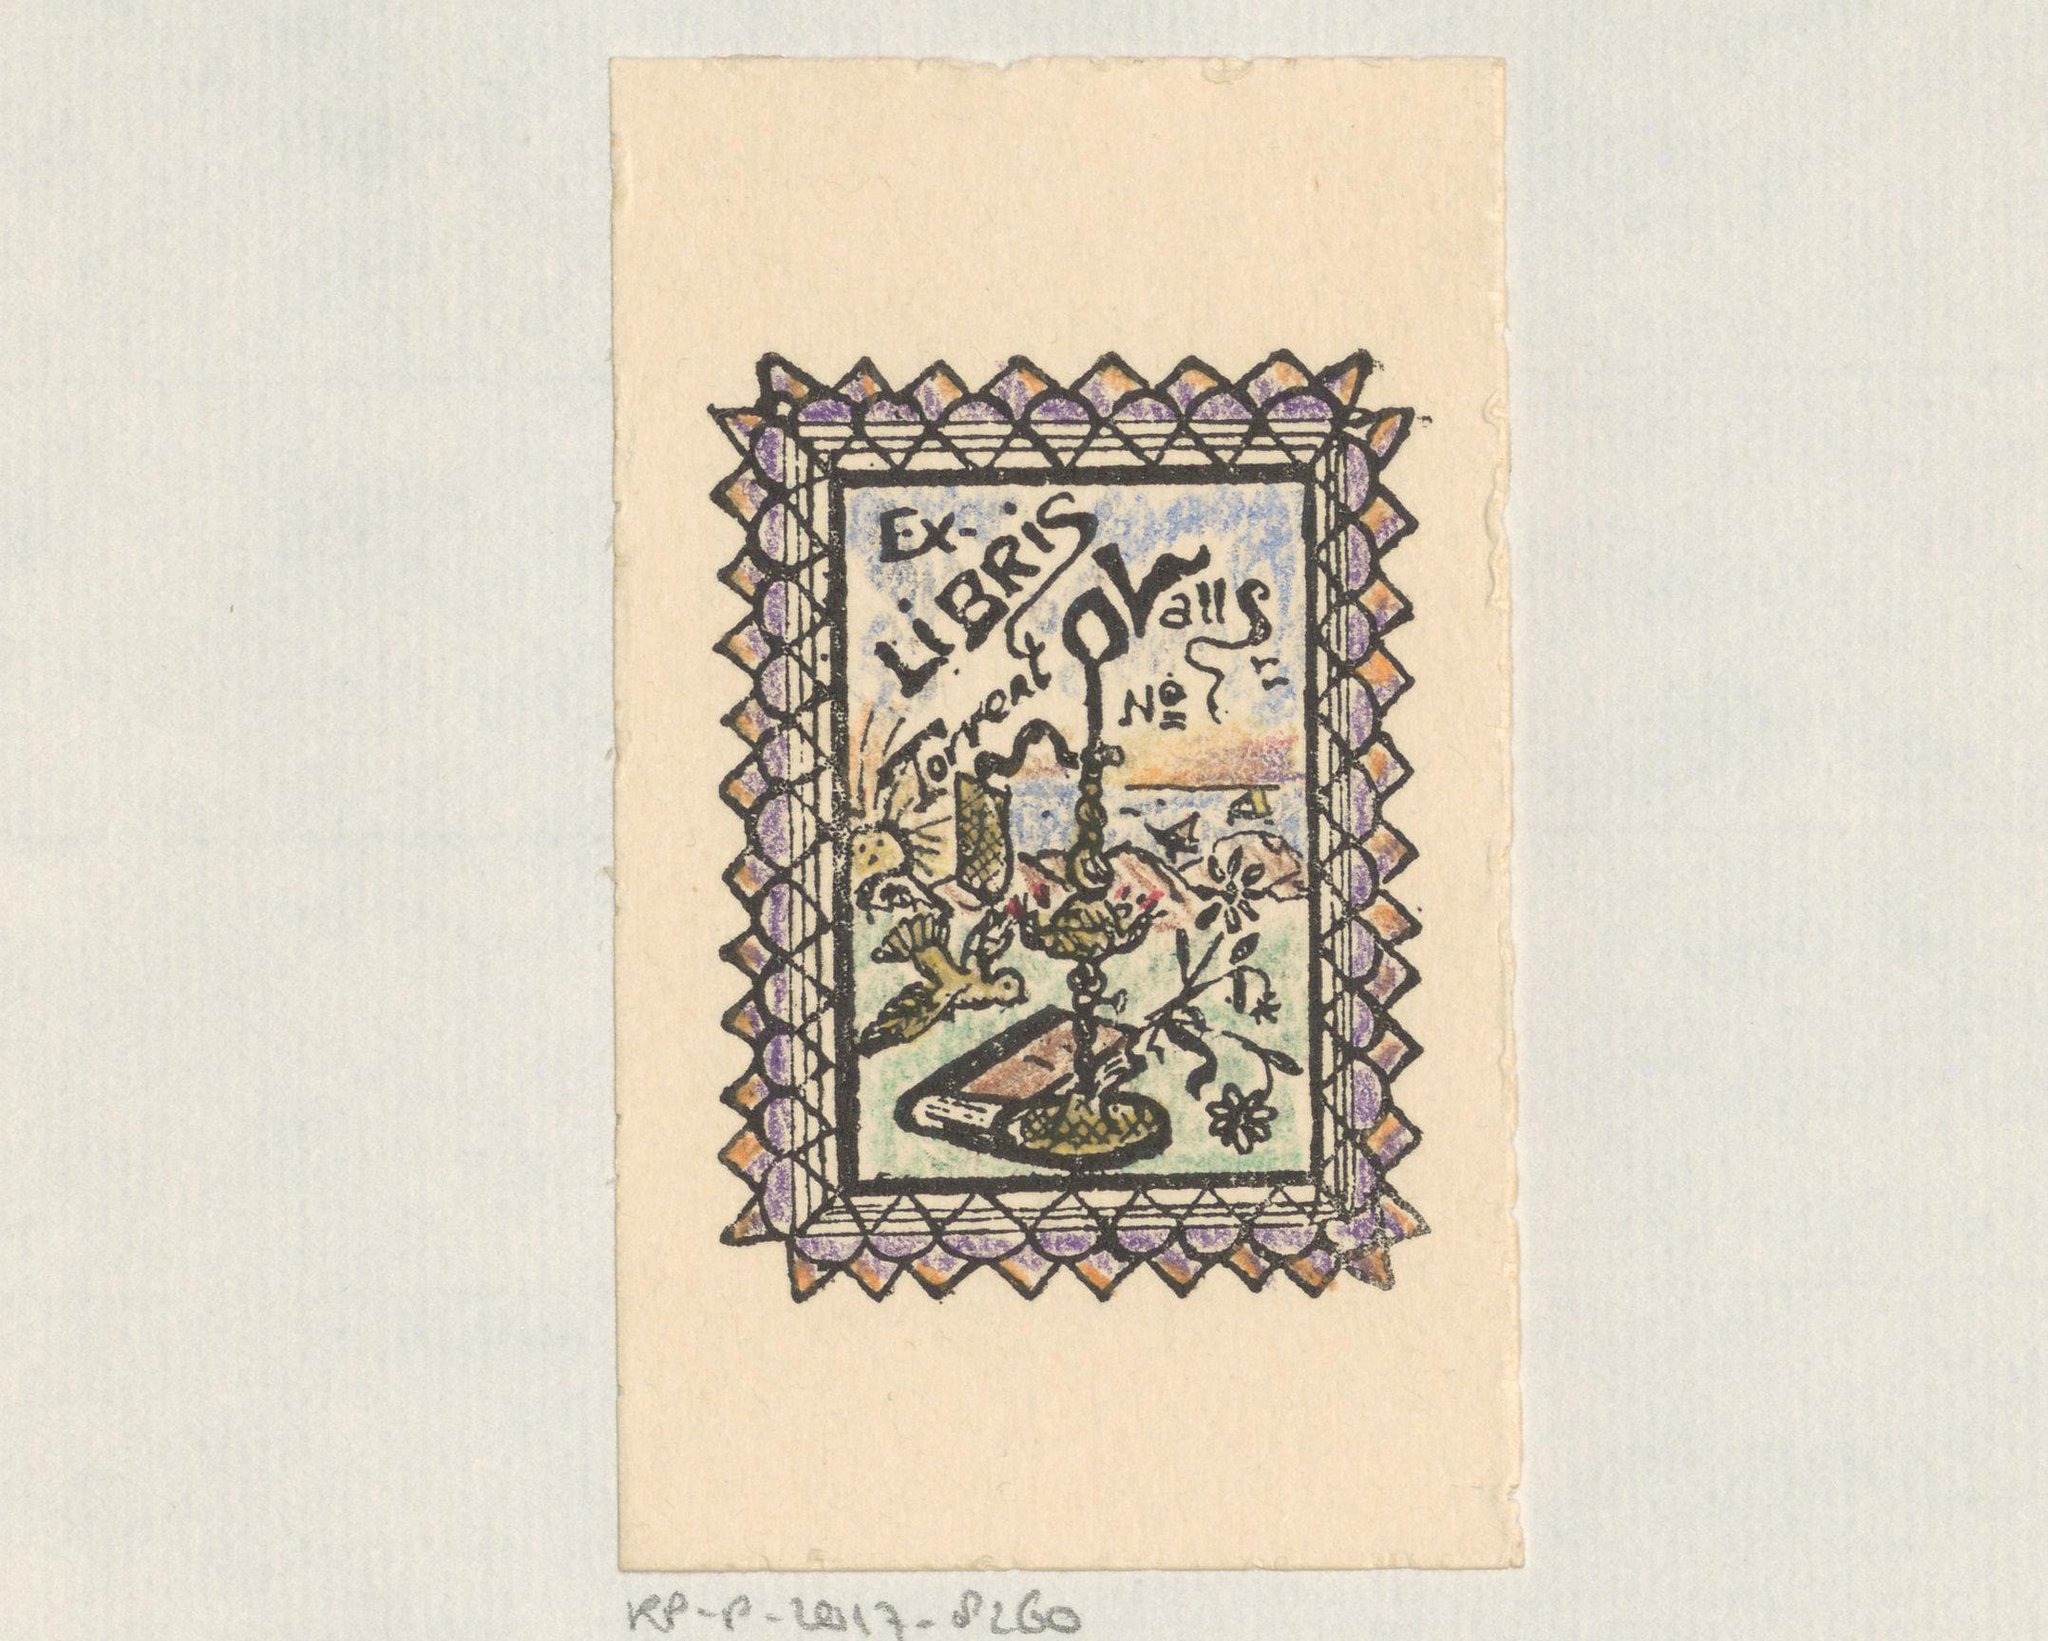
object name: bookplate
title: Ex libris, mogelijk van Torreat Valls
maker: Anonymous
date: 1900-1999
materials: chalk, paper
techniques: drawing, printing block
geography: spain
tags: birds, book